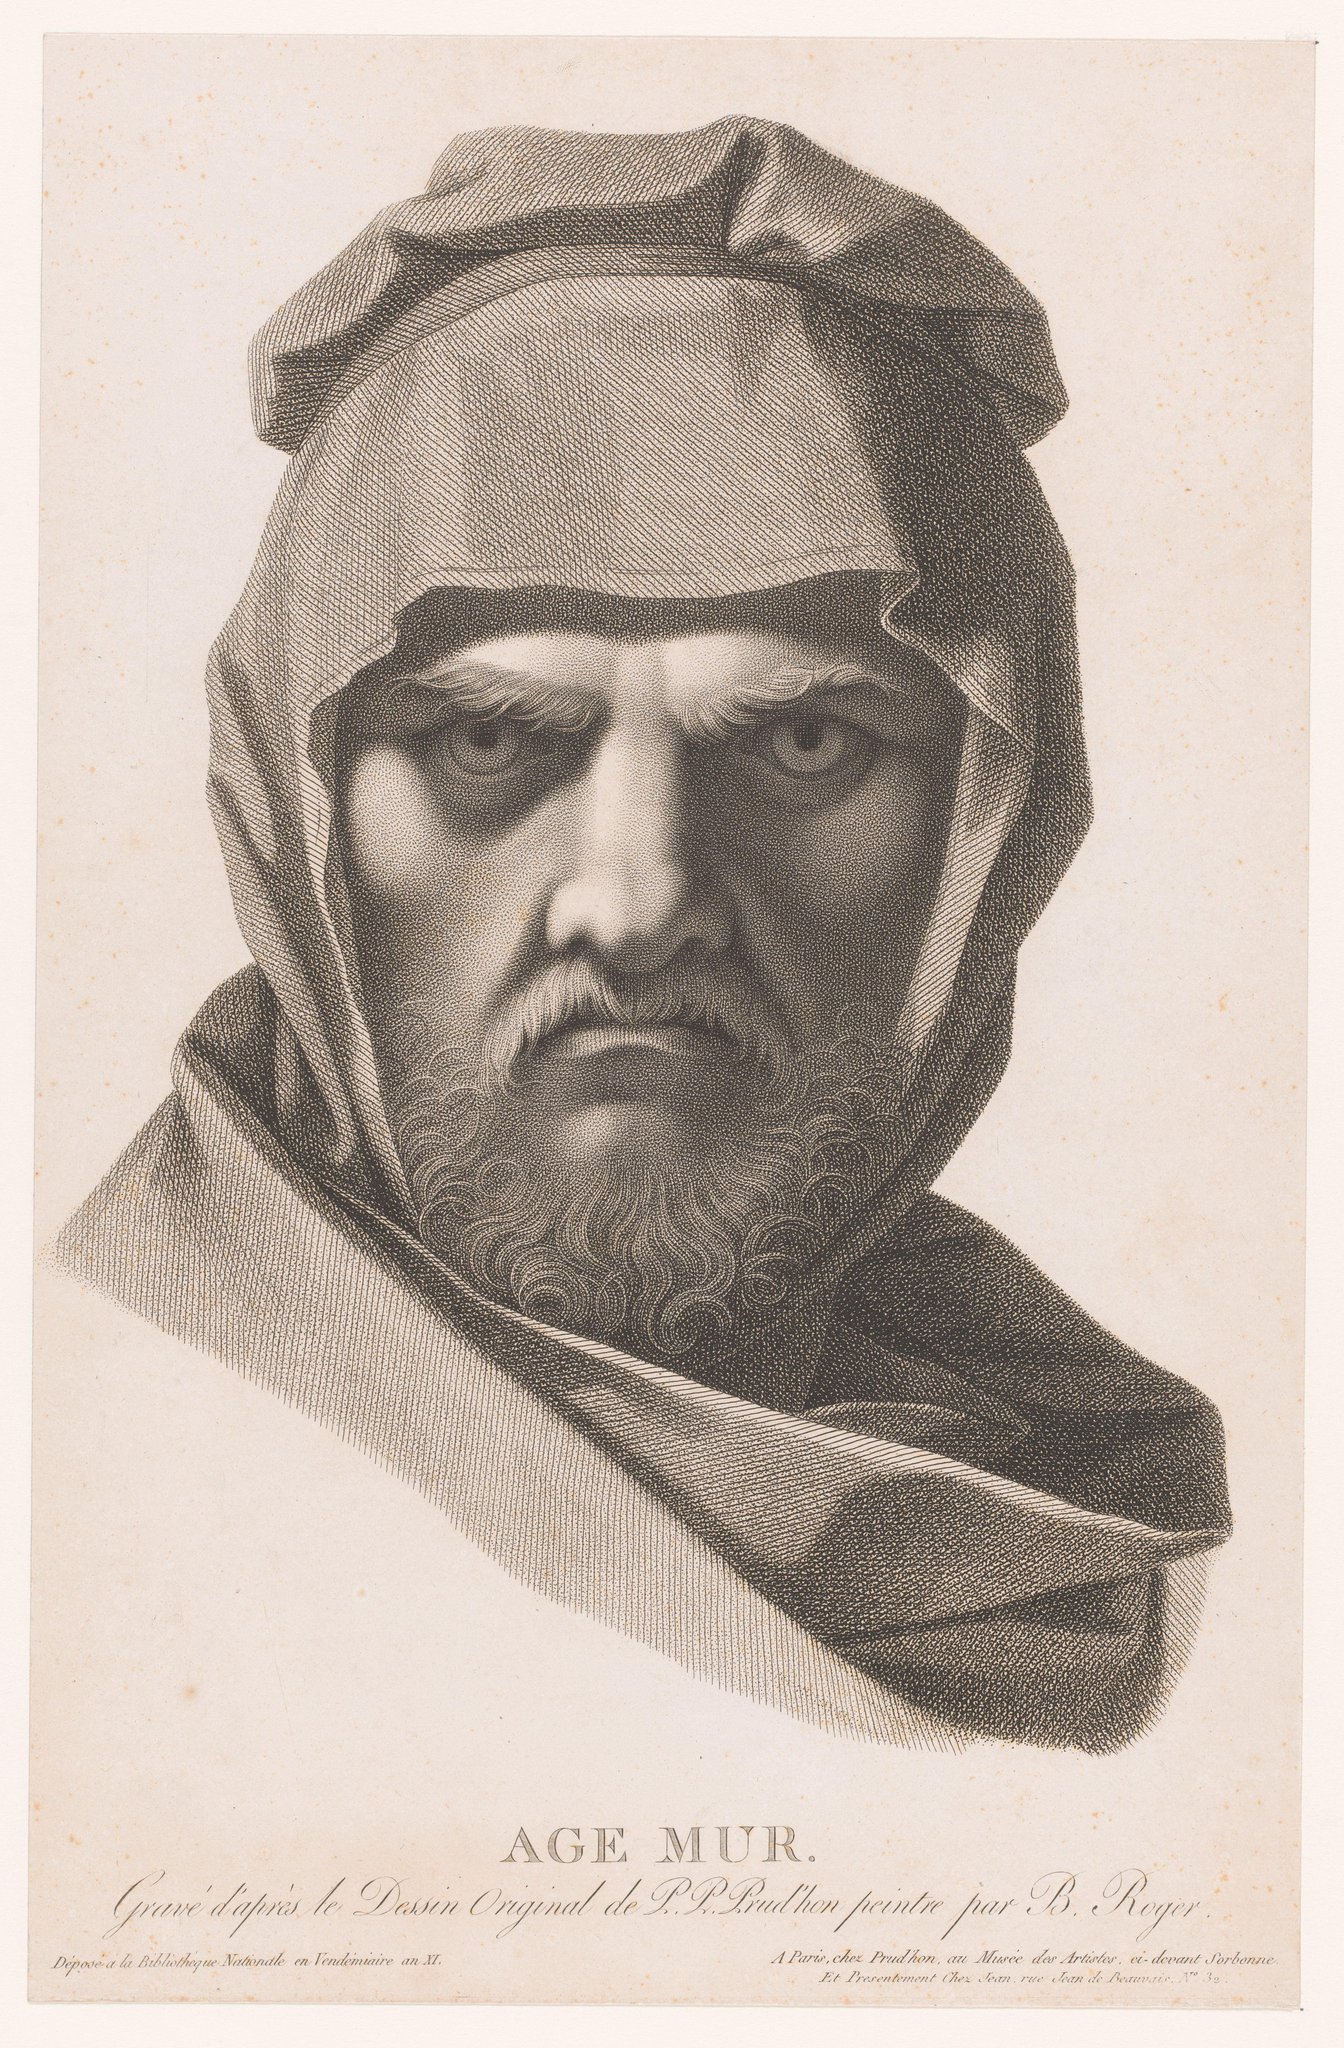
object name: print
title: Kop van man met baard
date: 1802-1803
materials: paper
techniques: engraving, etching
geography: paris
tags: adult man, beard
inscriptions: : ‘Déposé à la Bibliothèque Nationale’, collector's mark: Lugt 2228